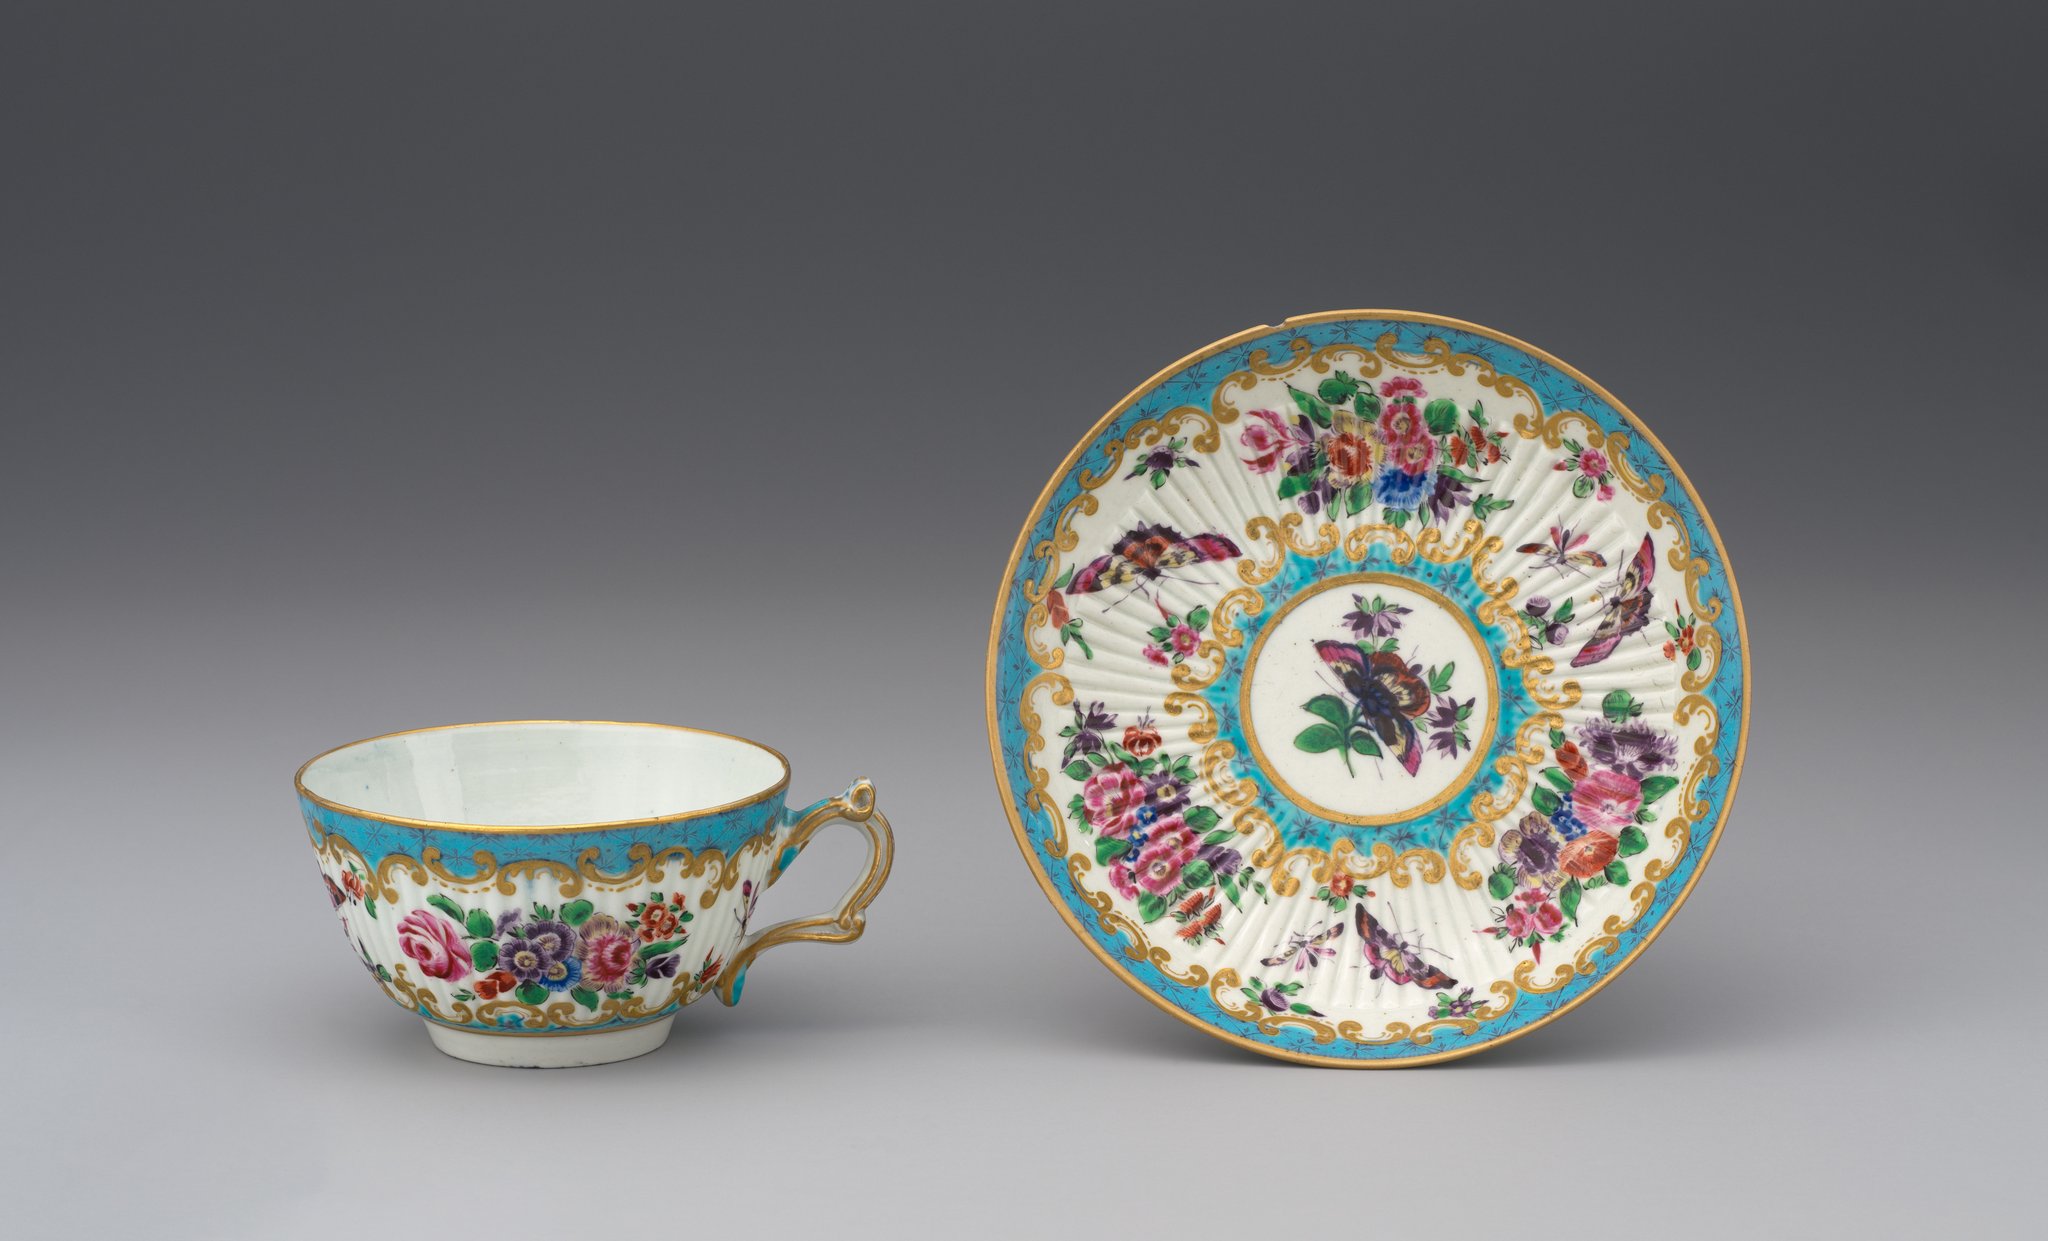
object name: cup and saucer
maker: worcester factory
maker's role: factory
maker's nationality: british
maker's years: 1751-2008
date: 1780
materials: soft paste porcelain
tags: insects,butterflies